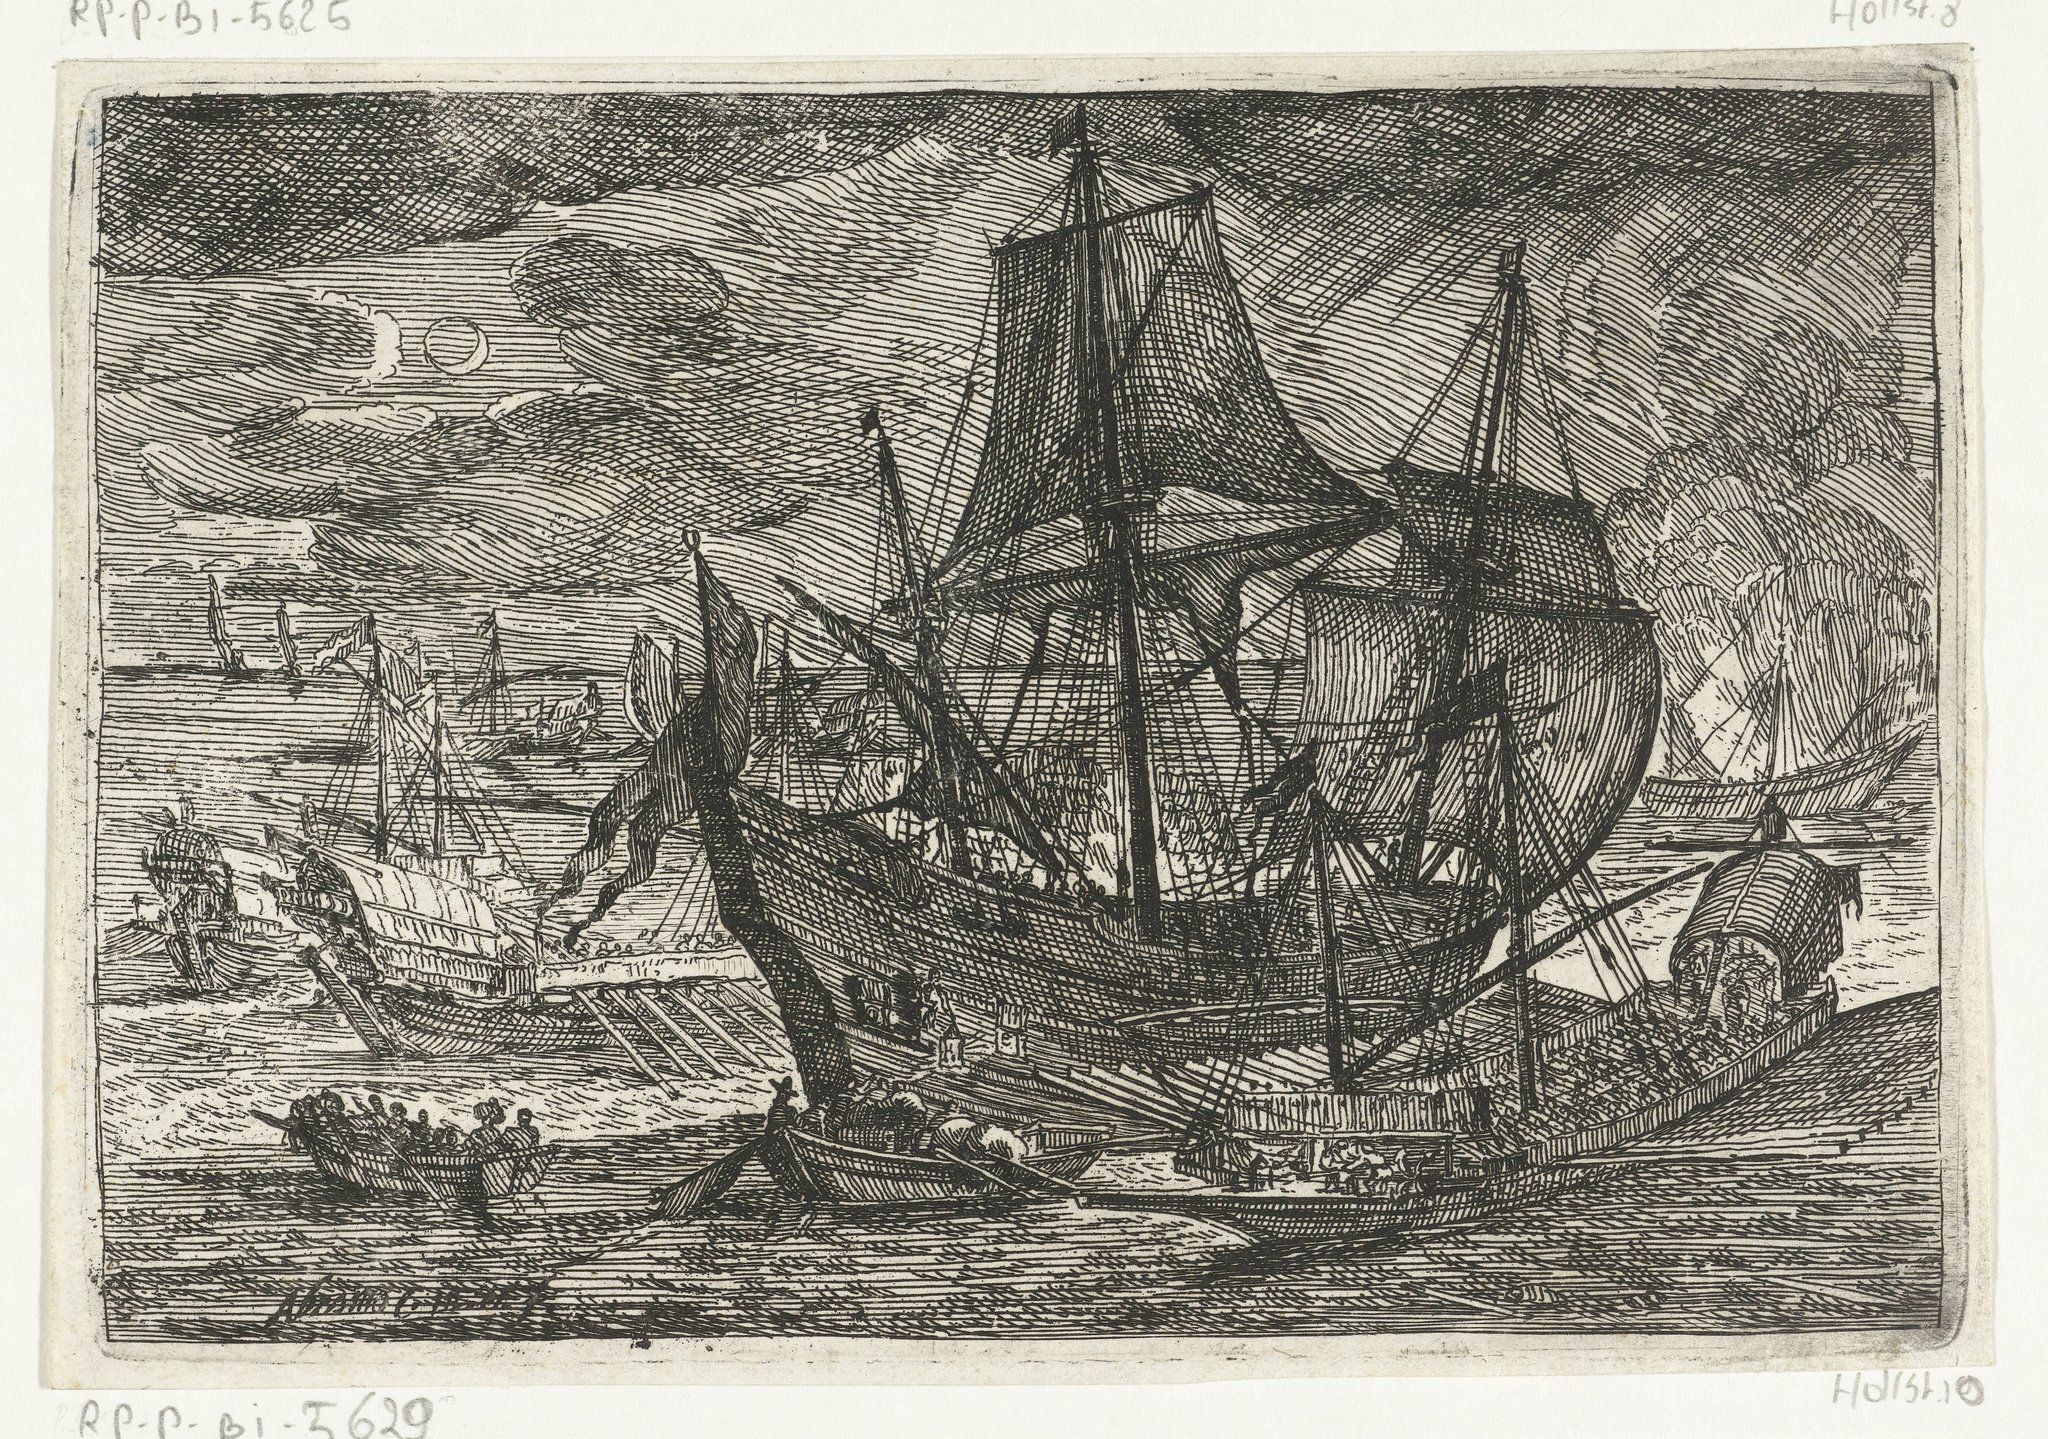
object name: print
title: Galeien op zee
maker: abraham de casembroot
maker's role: draughtsman, print maker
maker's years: 1573-1658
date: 1603-1658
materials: paper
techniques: etching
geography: southern netherlands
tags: warfare; military affairs (+ oared ships, e.g.: galley), sea (seascape), battle (+ oared ships, e.g.: galley)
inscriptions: collector's mark: Lugt 2166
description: Gezicht op de zee. Het is nacht. Op de voorgrond varen vier galeien. De grootste galei heeft pas vuur gevat. Op de achtergrond een ander brandend schip. Twee roeiboten met matrozen van het brandende schip varen naar de andere schepen. Prent uit serie van dertien prenten met gezichten van de haven van Messina